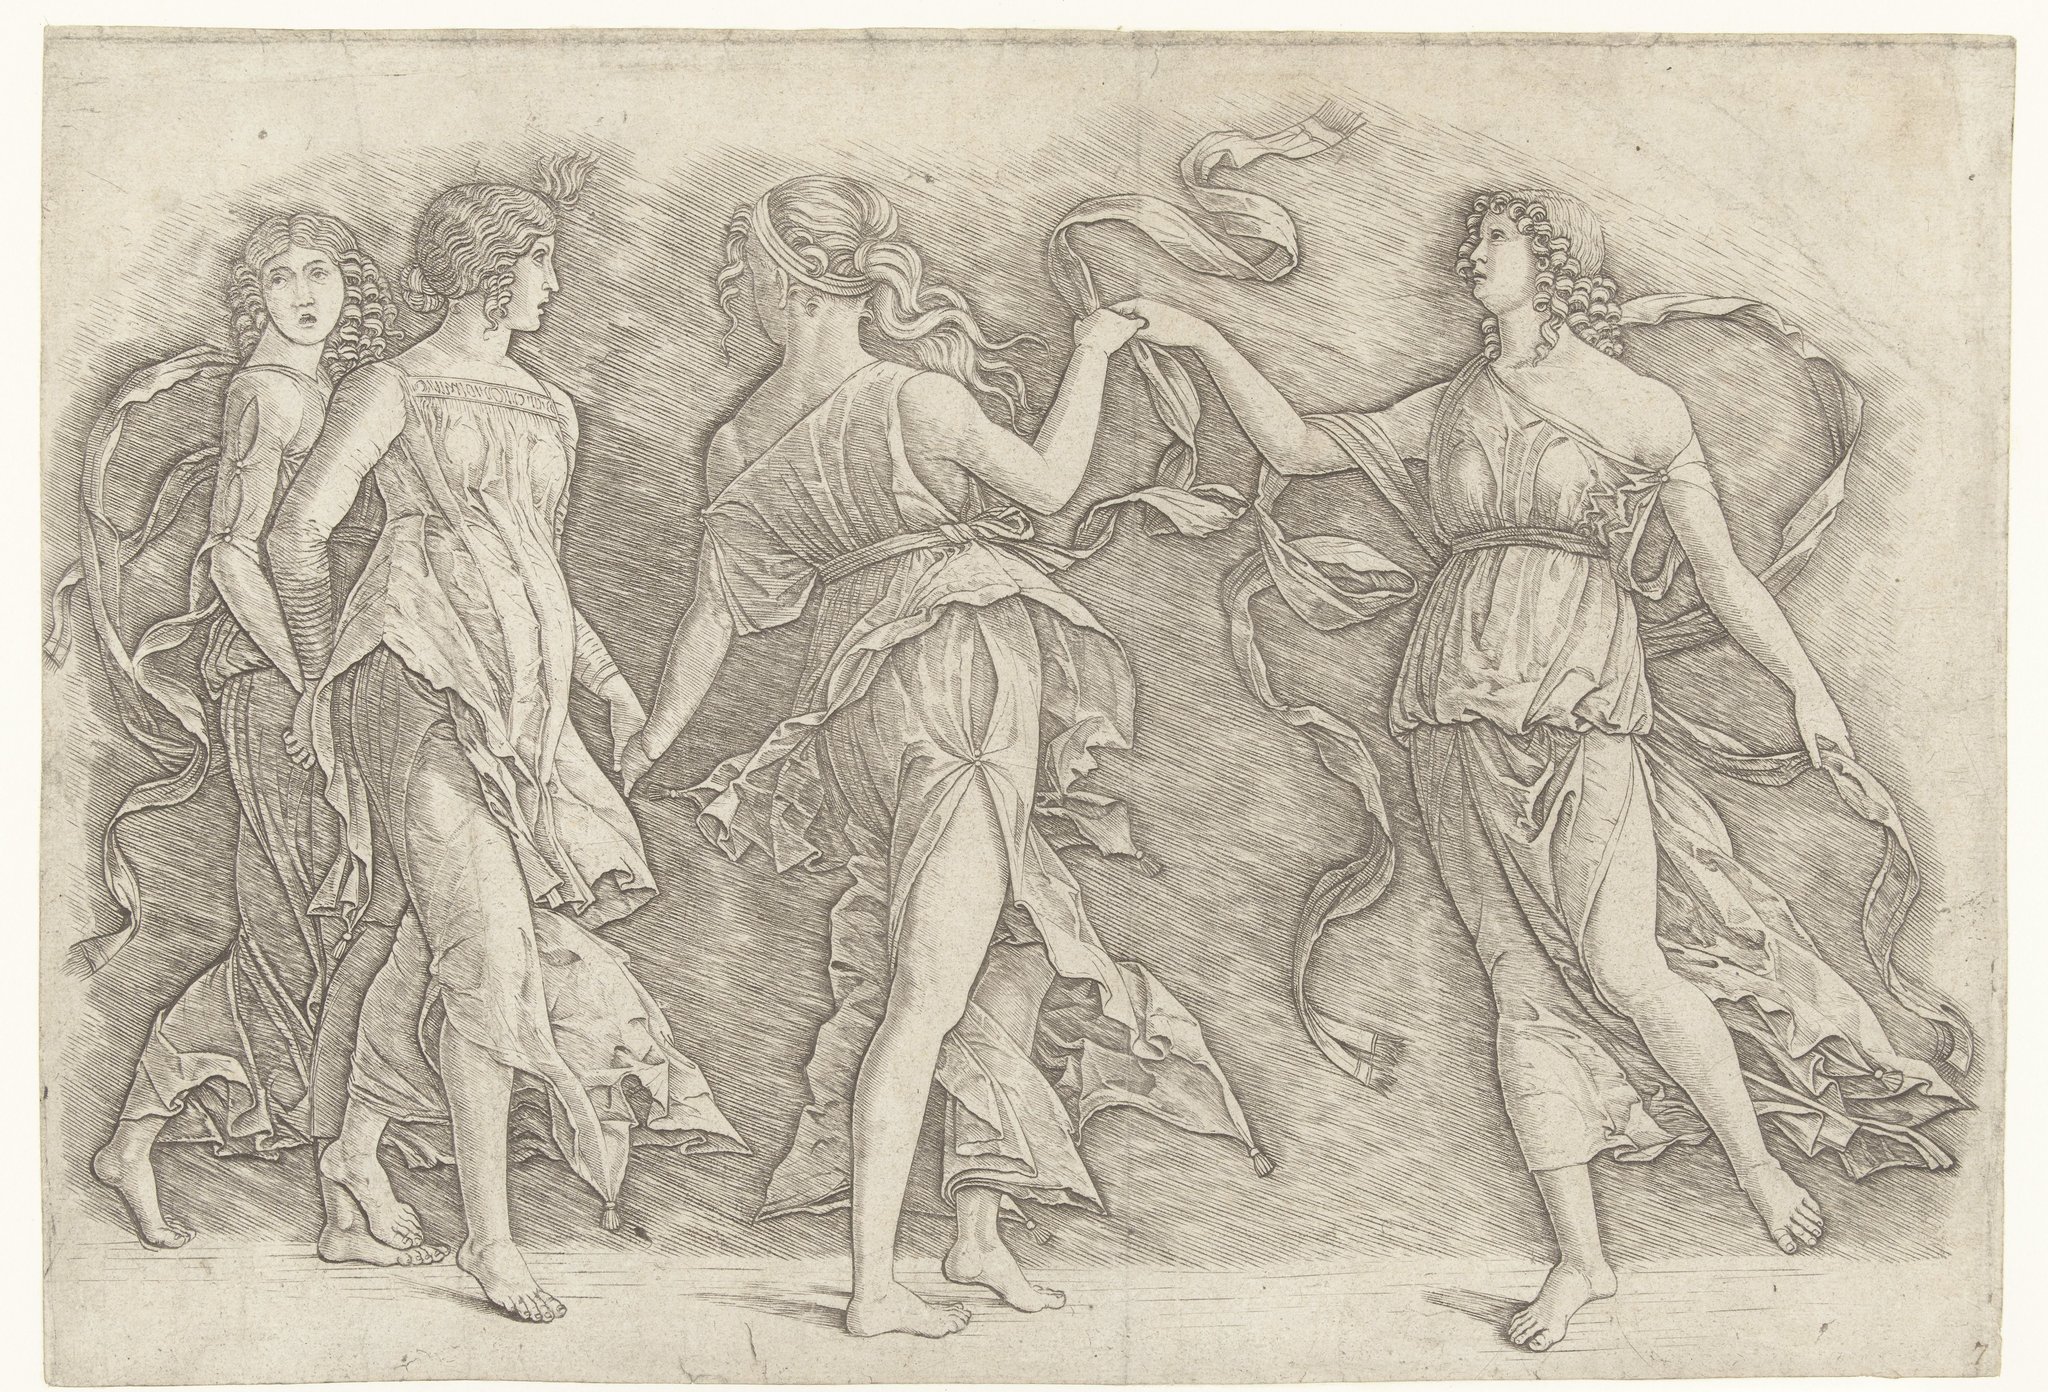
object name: print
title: Vier dansende vrouwen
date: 1497-1550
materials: paper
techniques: engraving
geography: italy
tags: dancing, female sex; woman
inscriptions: collector's mark: Lugt 11, collector's mark: Lugt 10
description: Herkomst collectie Hinloopen B 25 f 85-89 volgens aantekening op opzetkarton.